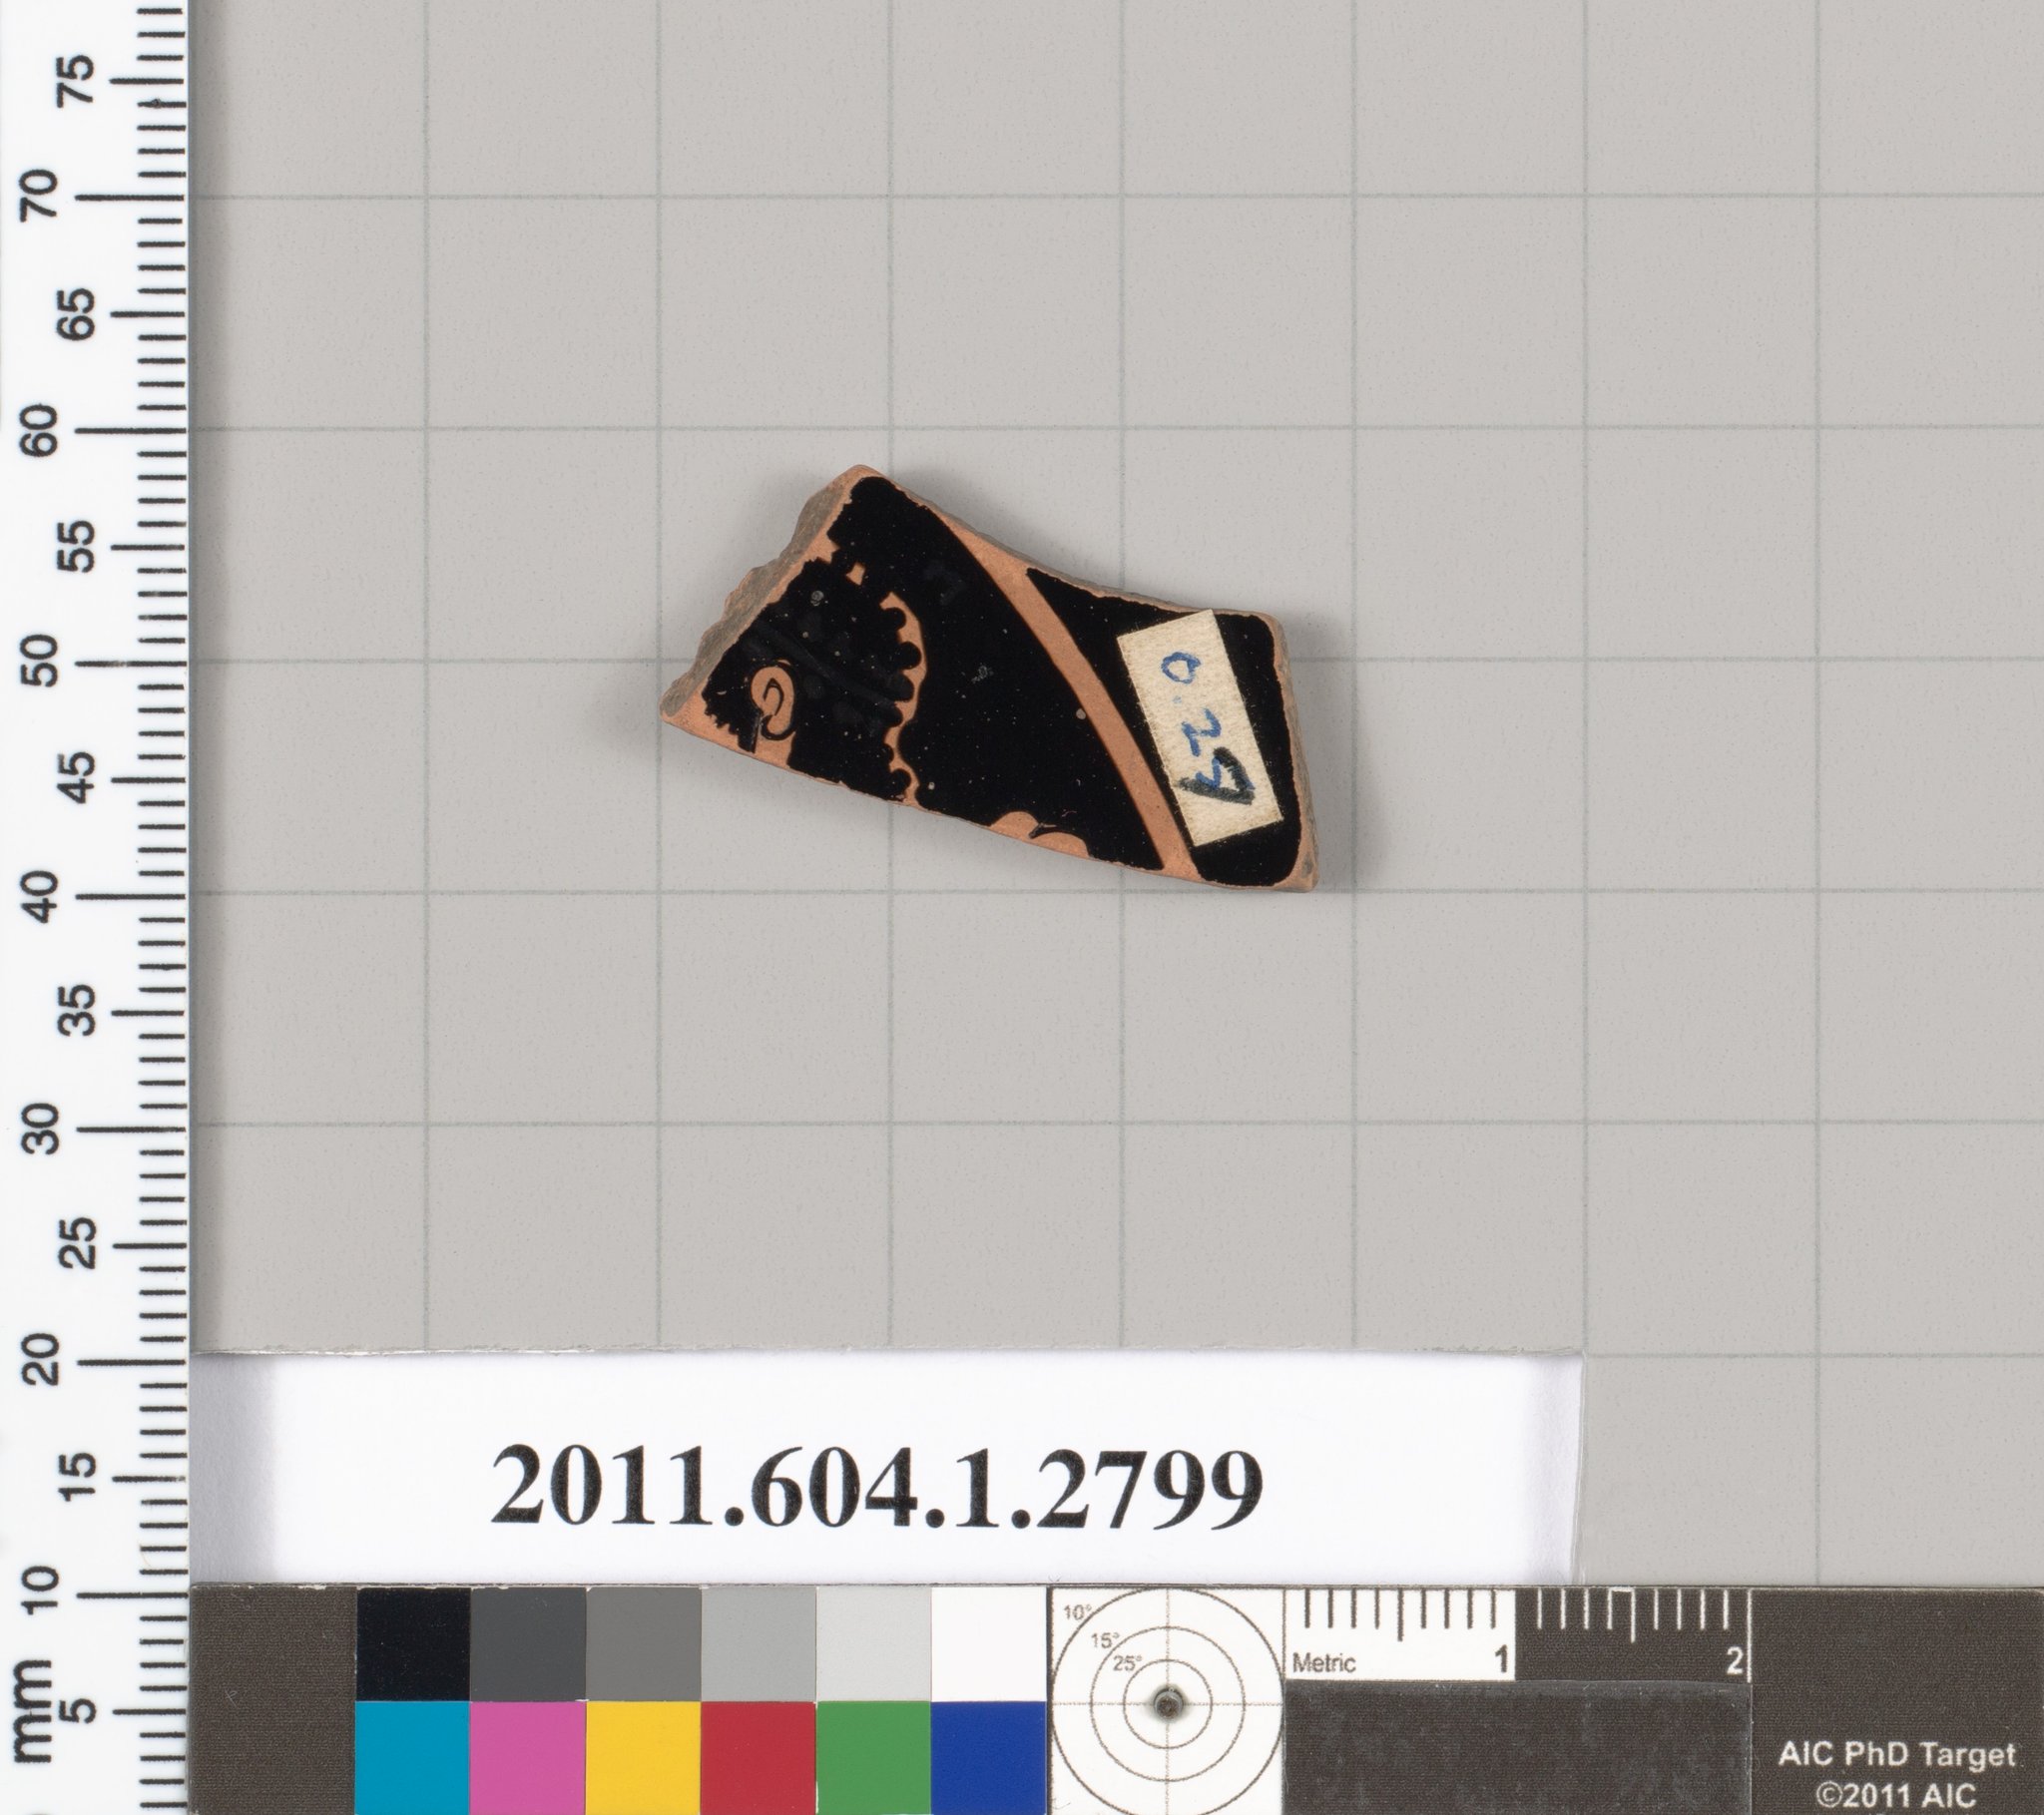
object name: kylix fragment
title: Terracotta fragment of a kylix (drinking cup)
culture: greek, attic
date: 520-500 BCE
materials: terracotta